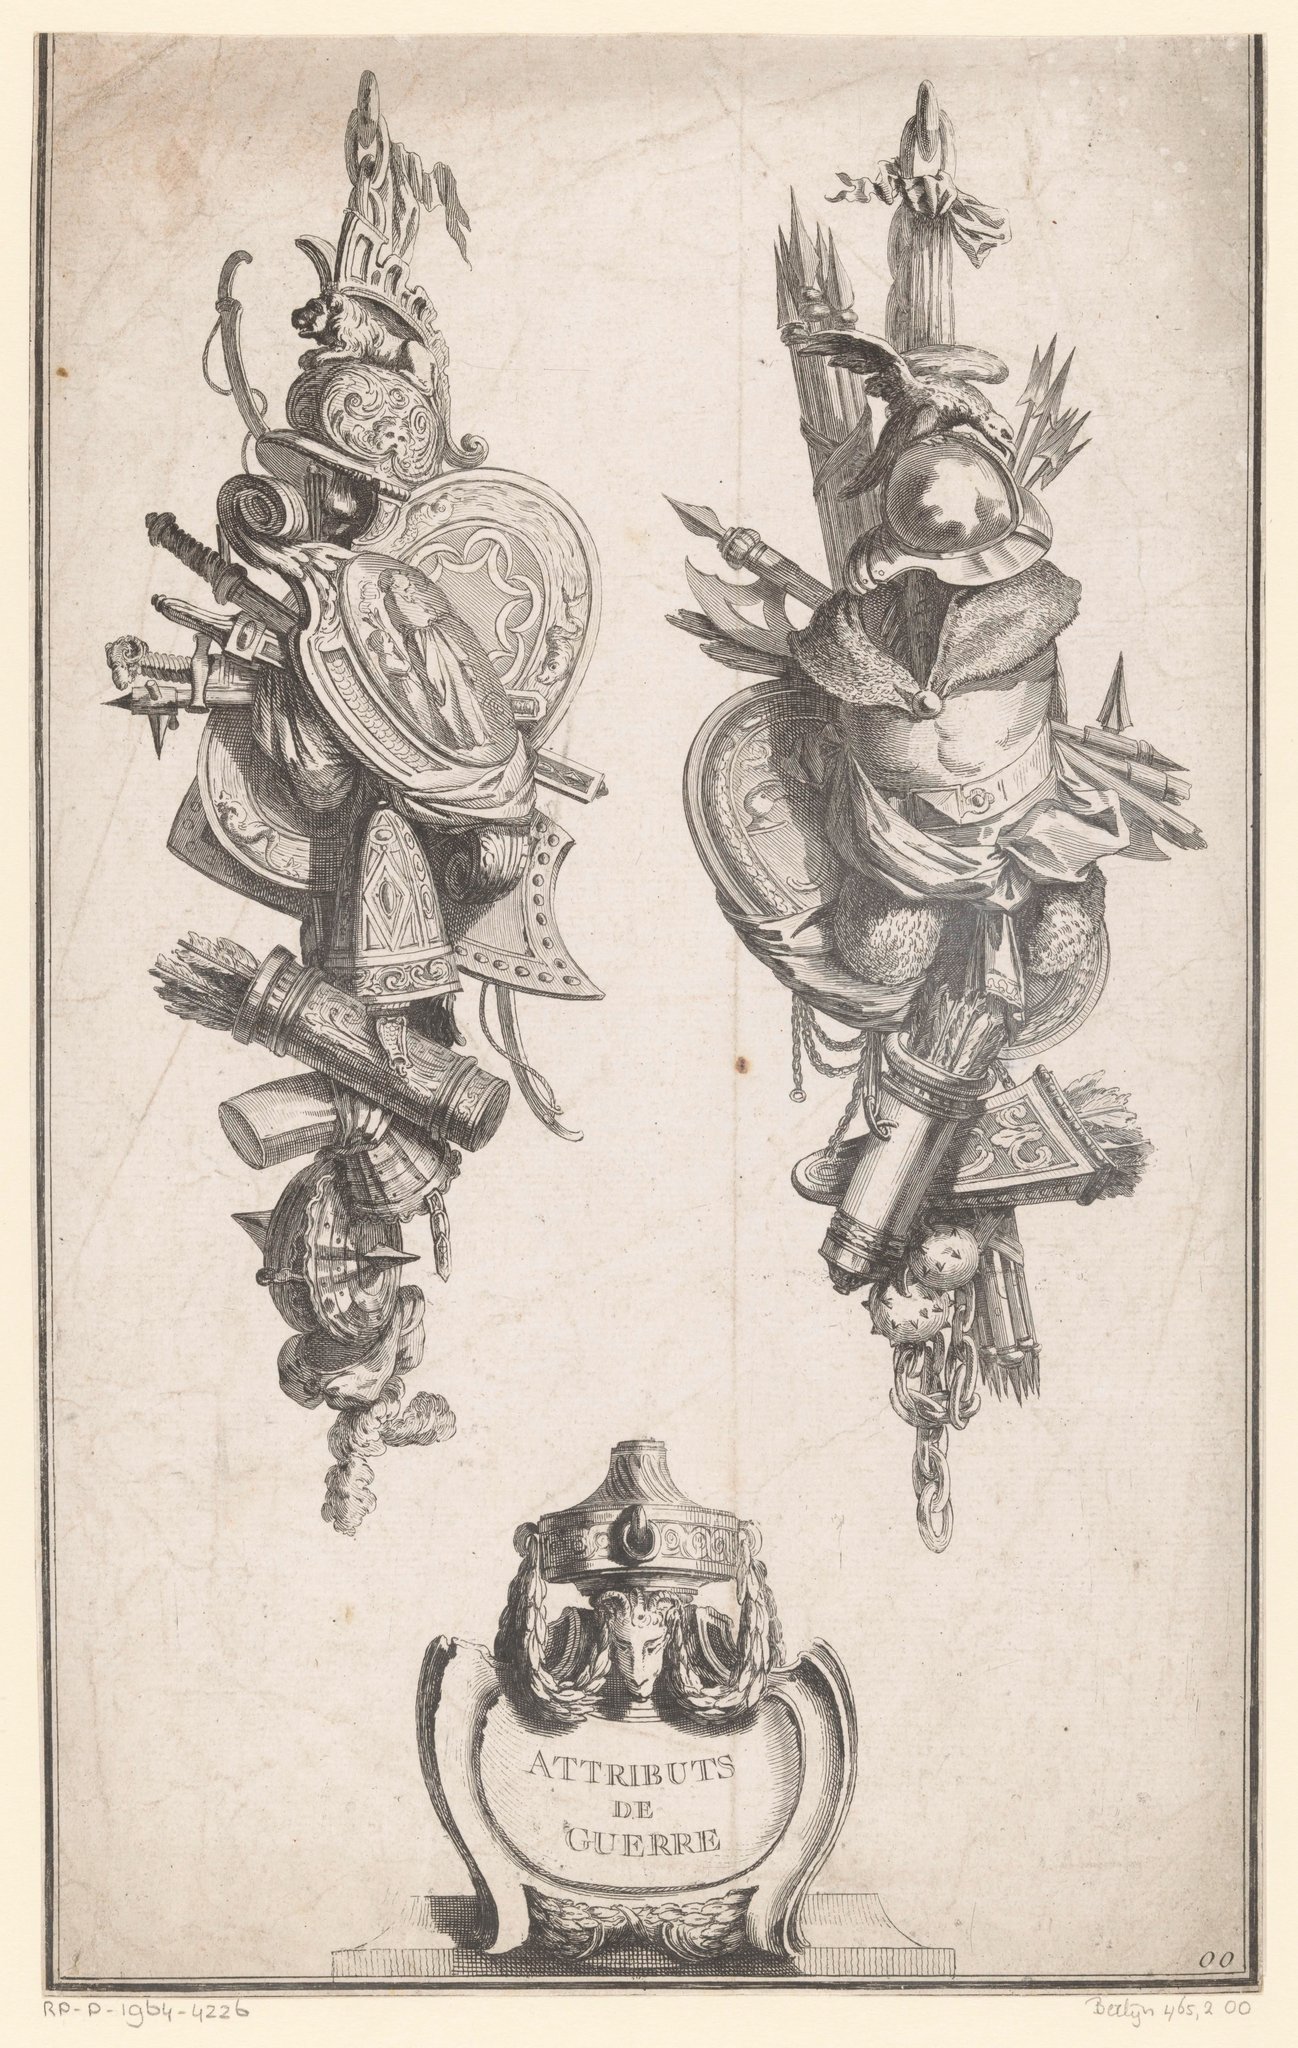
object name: ornament print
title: Trofeeën met schilden en harnas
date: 1771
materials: paper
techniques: engraving, etching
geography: paris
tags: trophy, i.e.: decorative arrangement of symbolic or typical objects ~ ornament, (military) equipment and supply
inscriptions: collector's mark: Lugt 2228, collector's mark: Lugt 2760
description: Links een trofee met een helm, diverse schilden en een pijlenkoker. Rechts een trofee met een helm met adelaar, een harnas, speren, een schild en pijlenkokers.